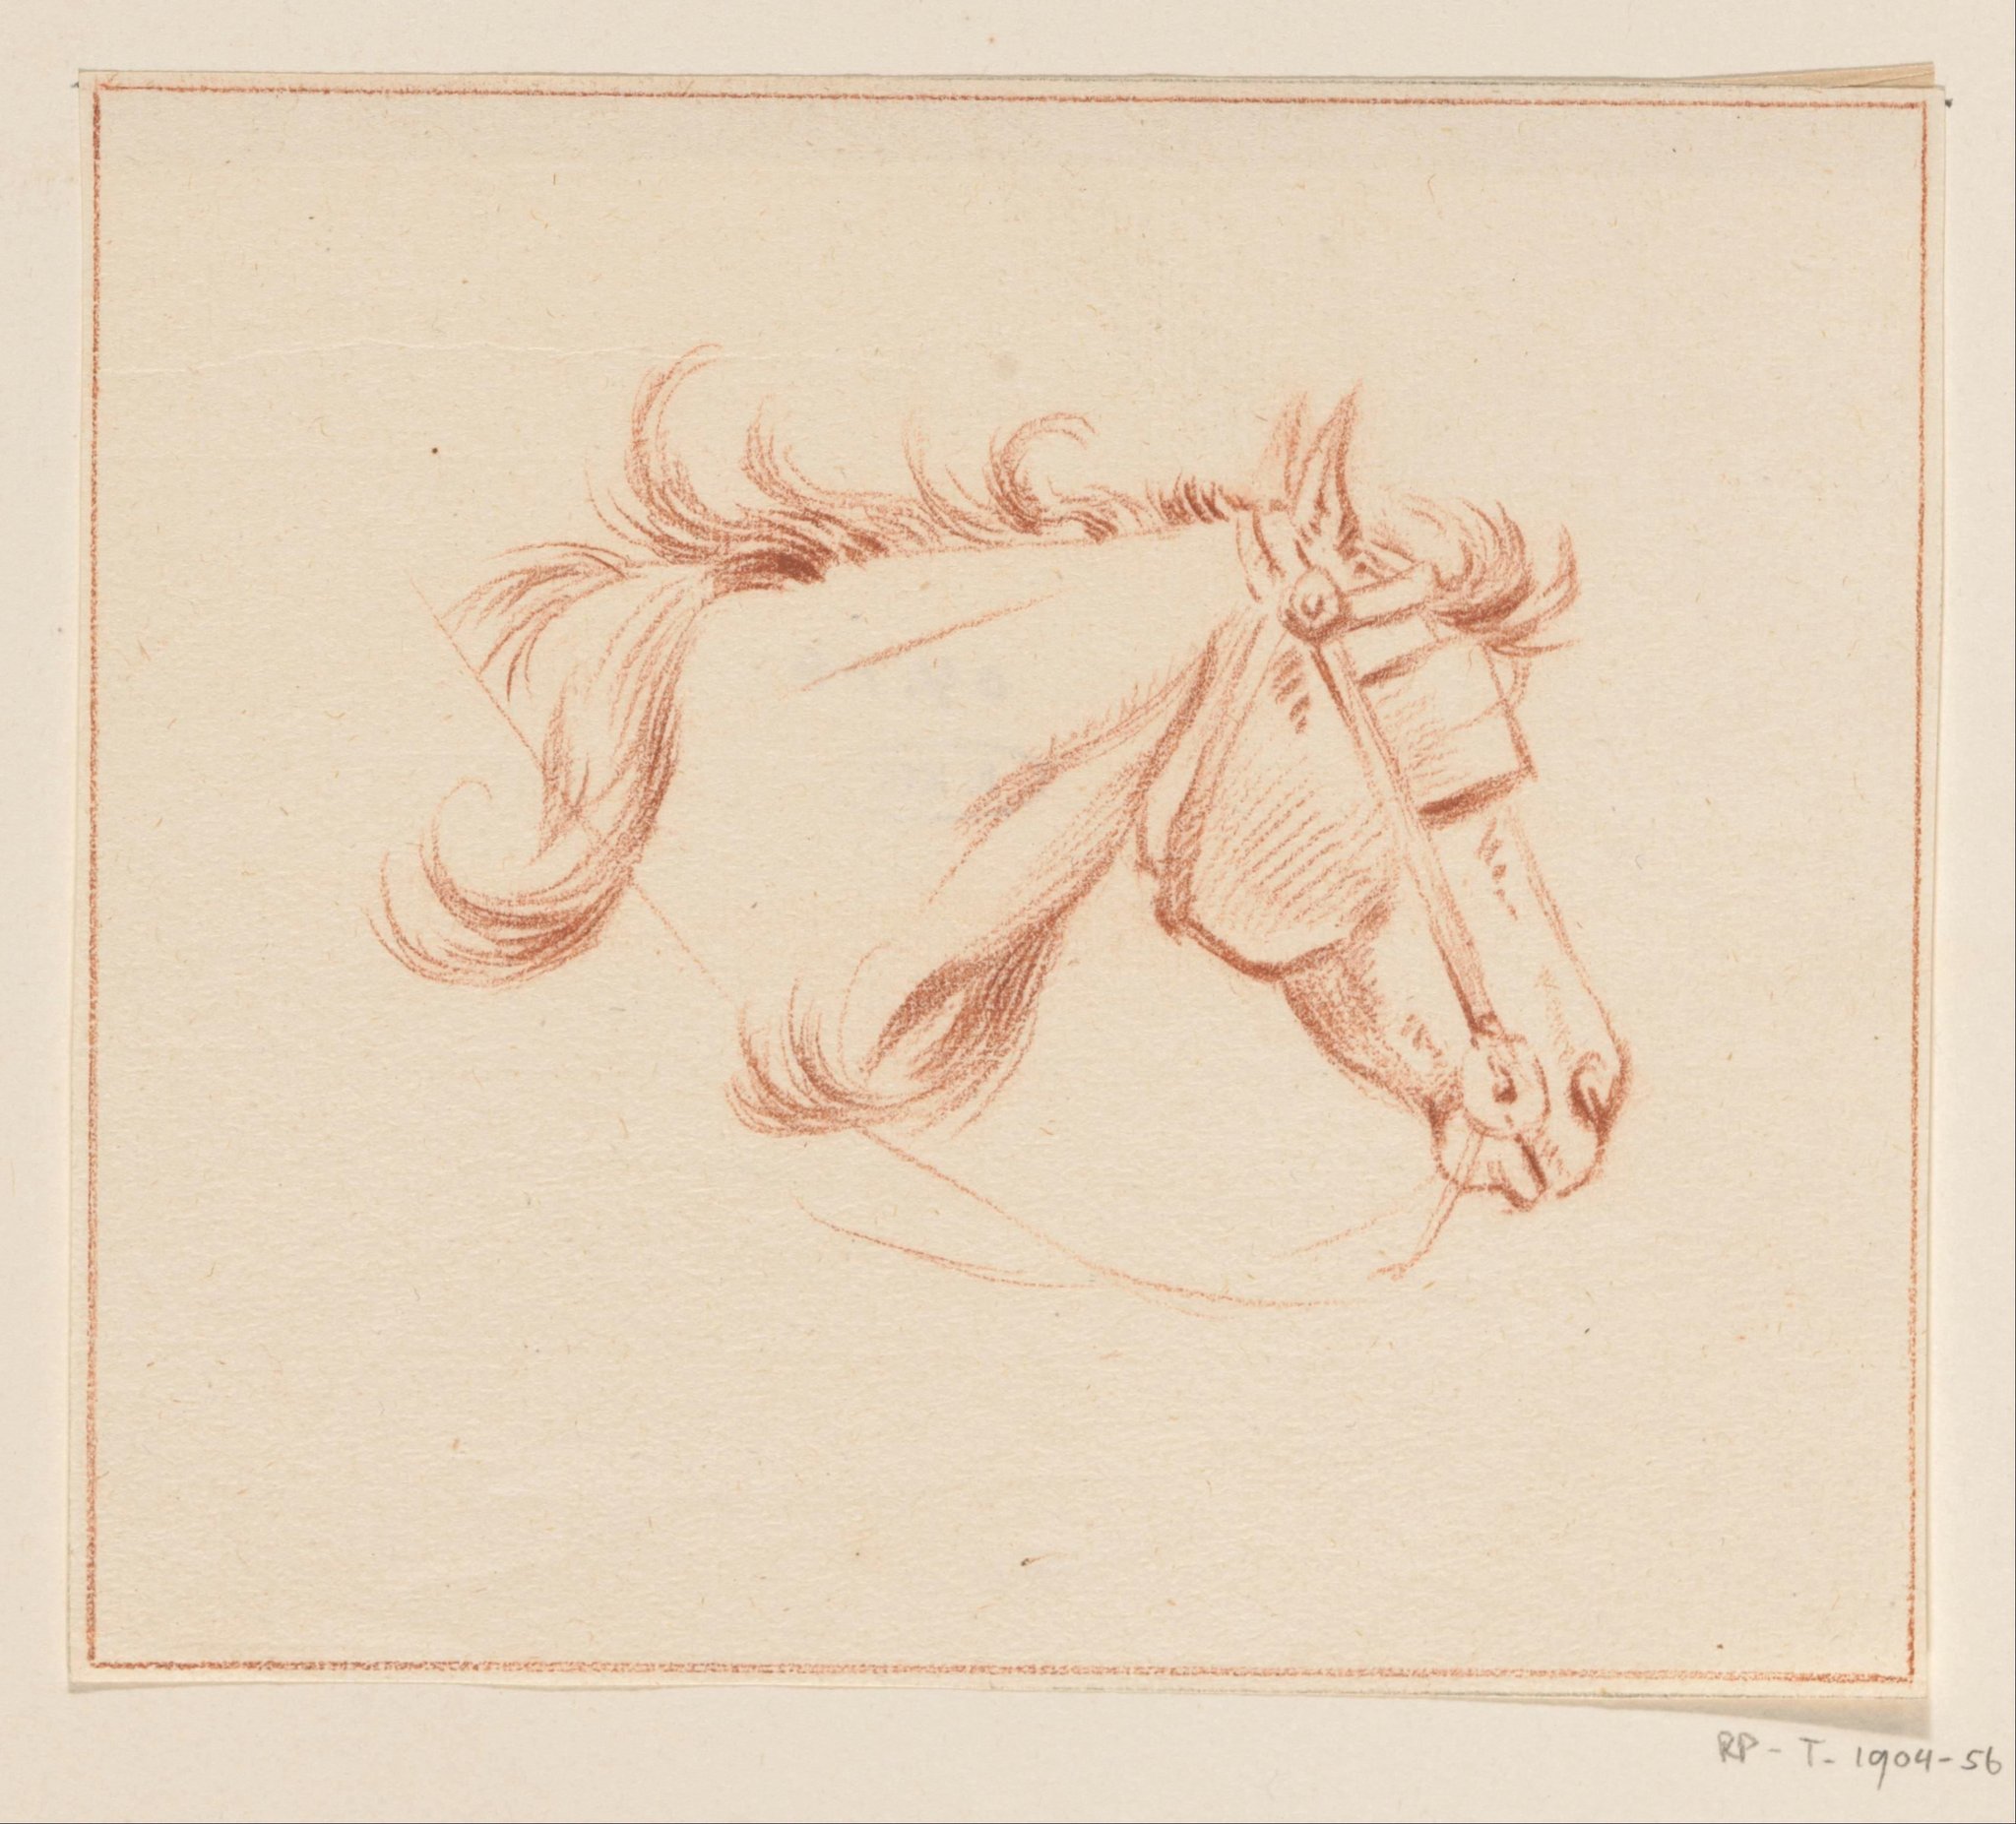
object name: drawing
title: Hoofd van een paard met oogkleppen, naar rechts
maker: jean bernard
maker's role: draughtsman, print maker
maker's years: 1765-1833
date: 1775-1833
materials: chalk, paper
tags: horse